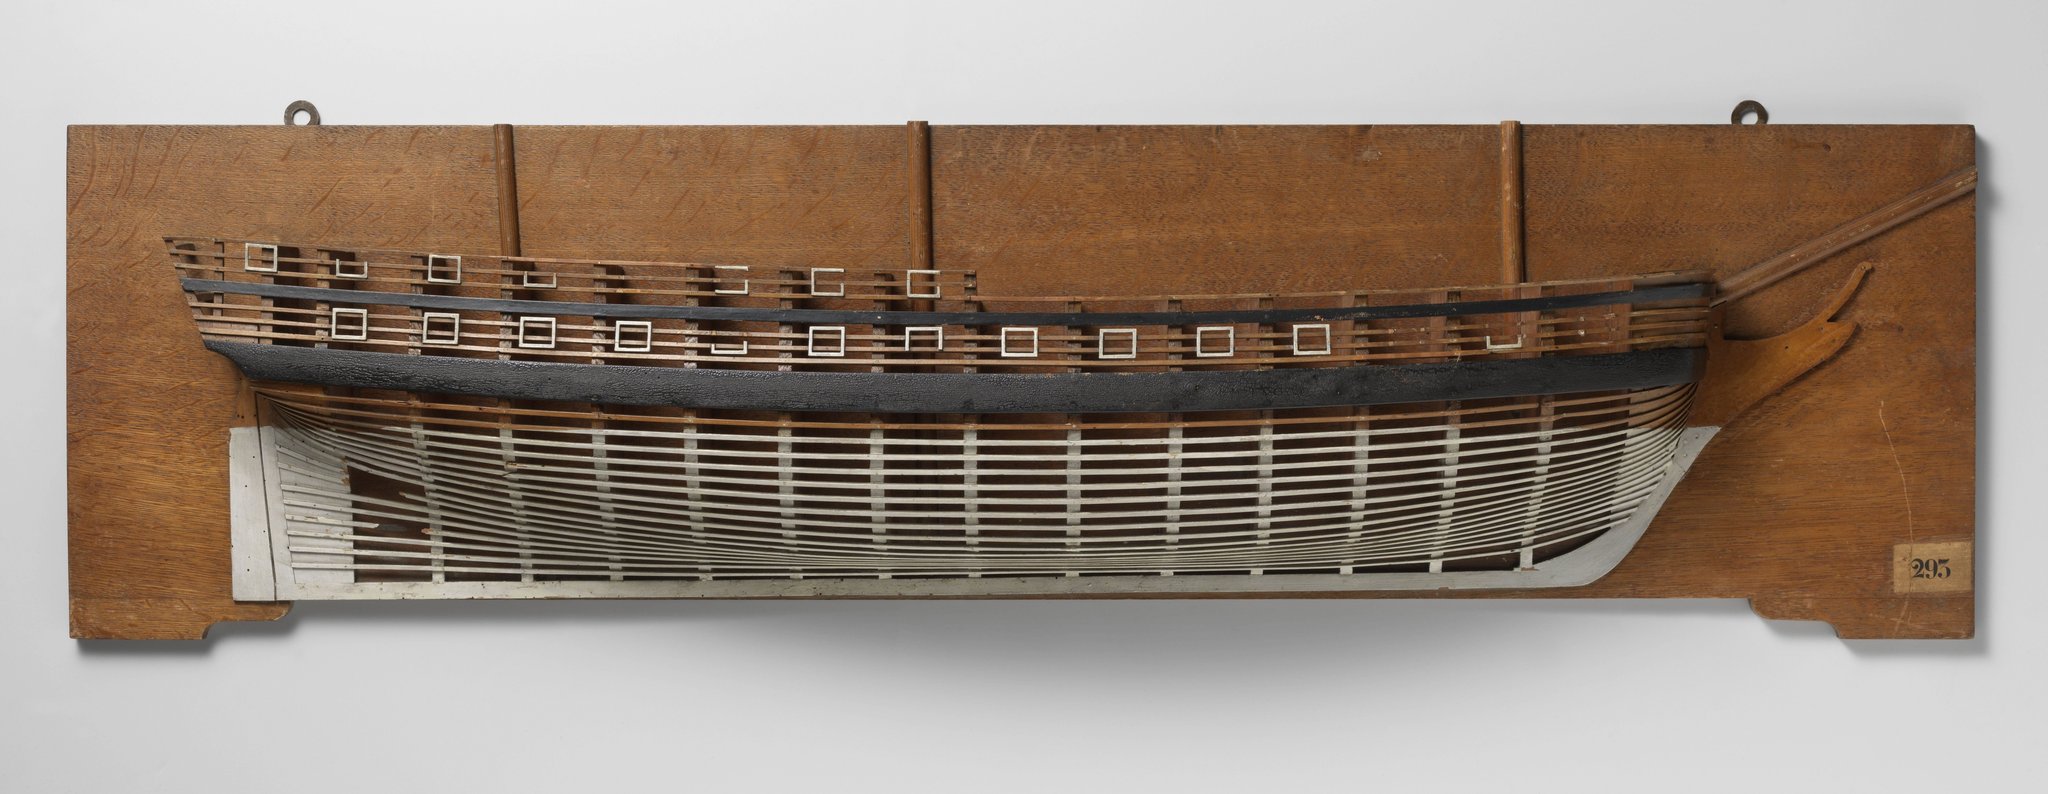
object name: half model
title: Half Model of a 44-Gun Frigate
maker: Anonymous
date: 1780-1825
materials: wood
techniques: polychromy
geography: netherlands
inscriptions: label, bottom right: ‘293’ former inventory label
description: Gepolychromeerd mallenmodel (stuurboord) van een driemaster. Twee en twintig geschutpoorten verdeeld over geschutdek en halfdek. Gewrongen spiegel, hol wulf, geen details van hek of zijgalerij; recht roer met vierkante roerkoning. Zeeg aan beide uiteinden iets oplopend, één berghout en één reehout. Gepiekt rondspant.